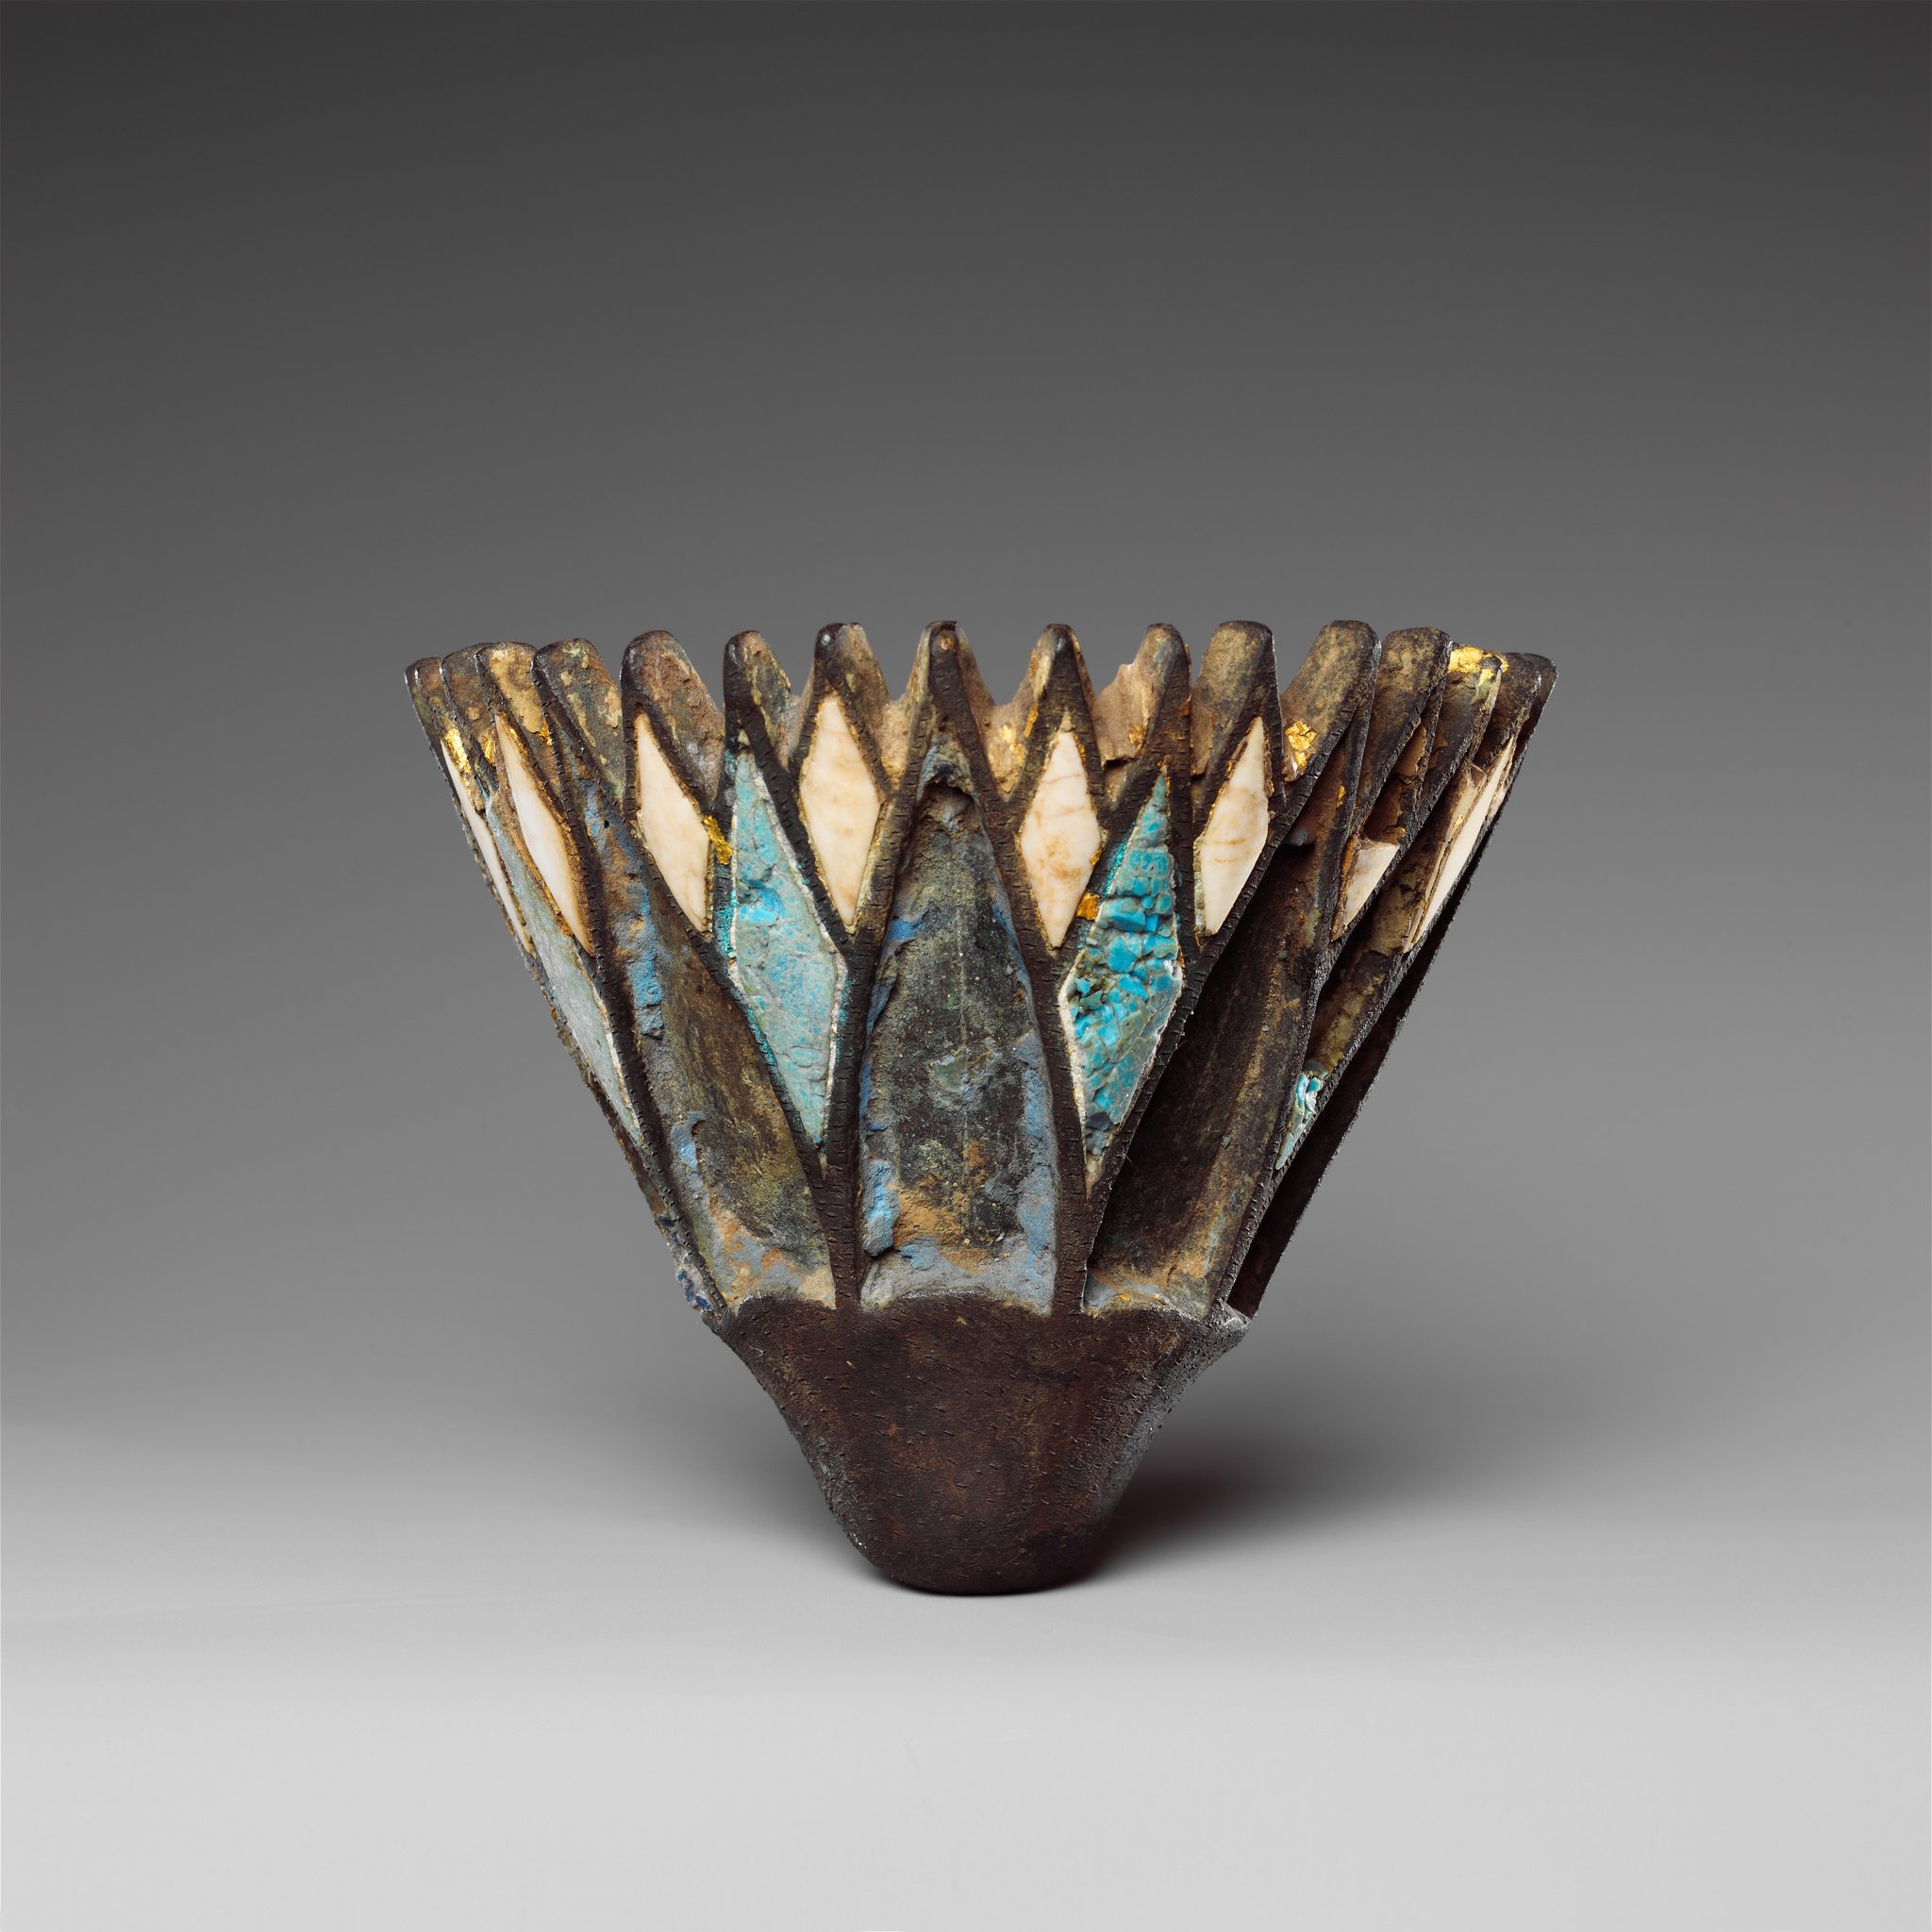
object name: statue or equipment attachment, lotus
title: Water lily attachment, probably for a processional barque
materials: bronze, gesso, glass, gold foil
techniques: inlay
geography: egypt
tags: lotuses